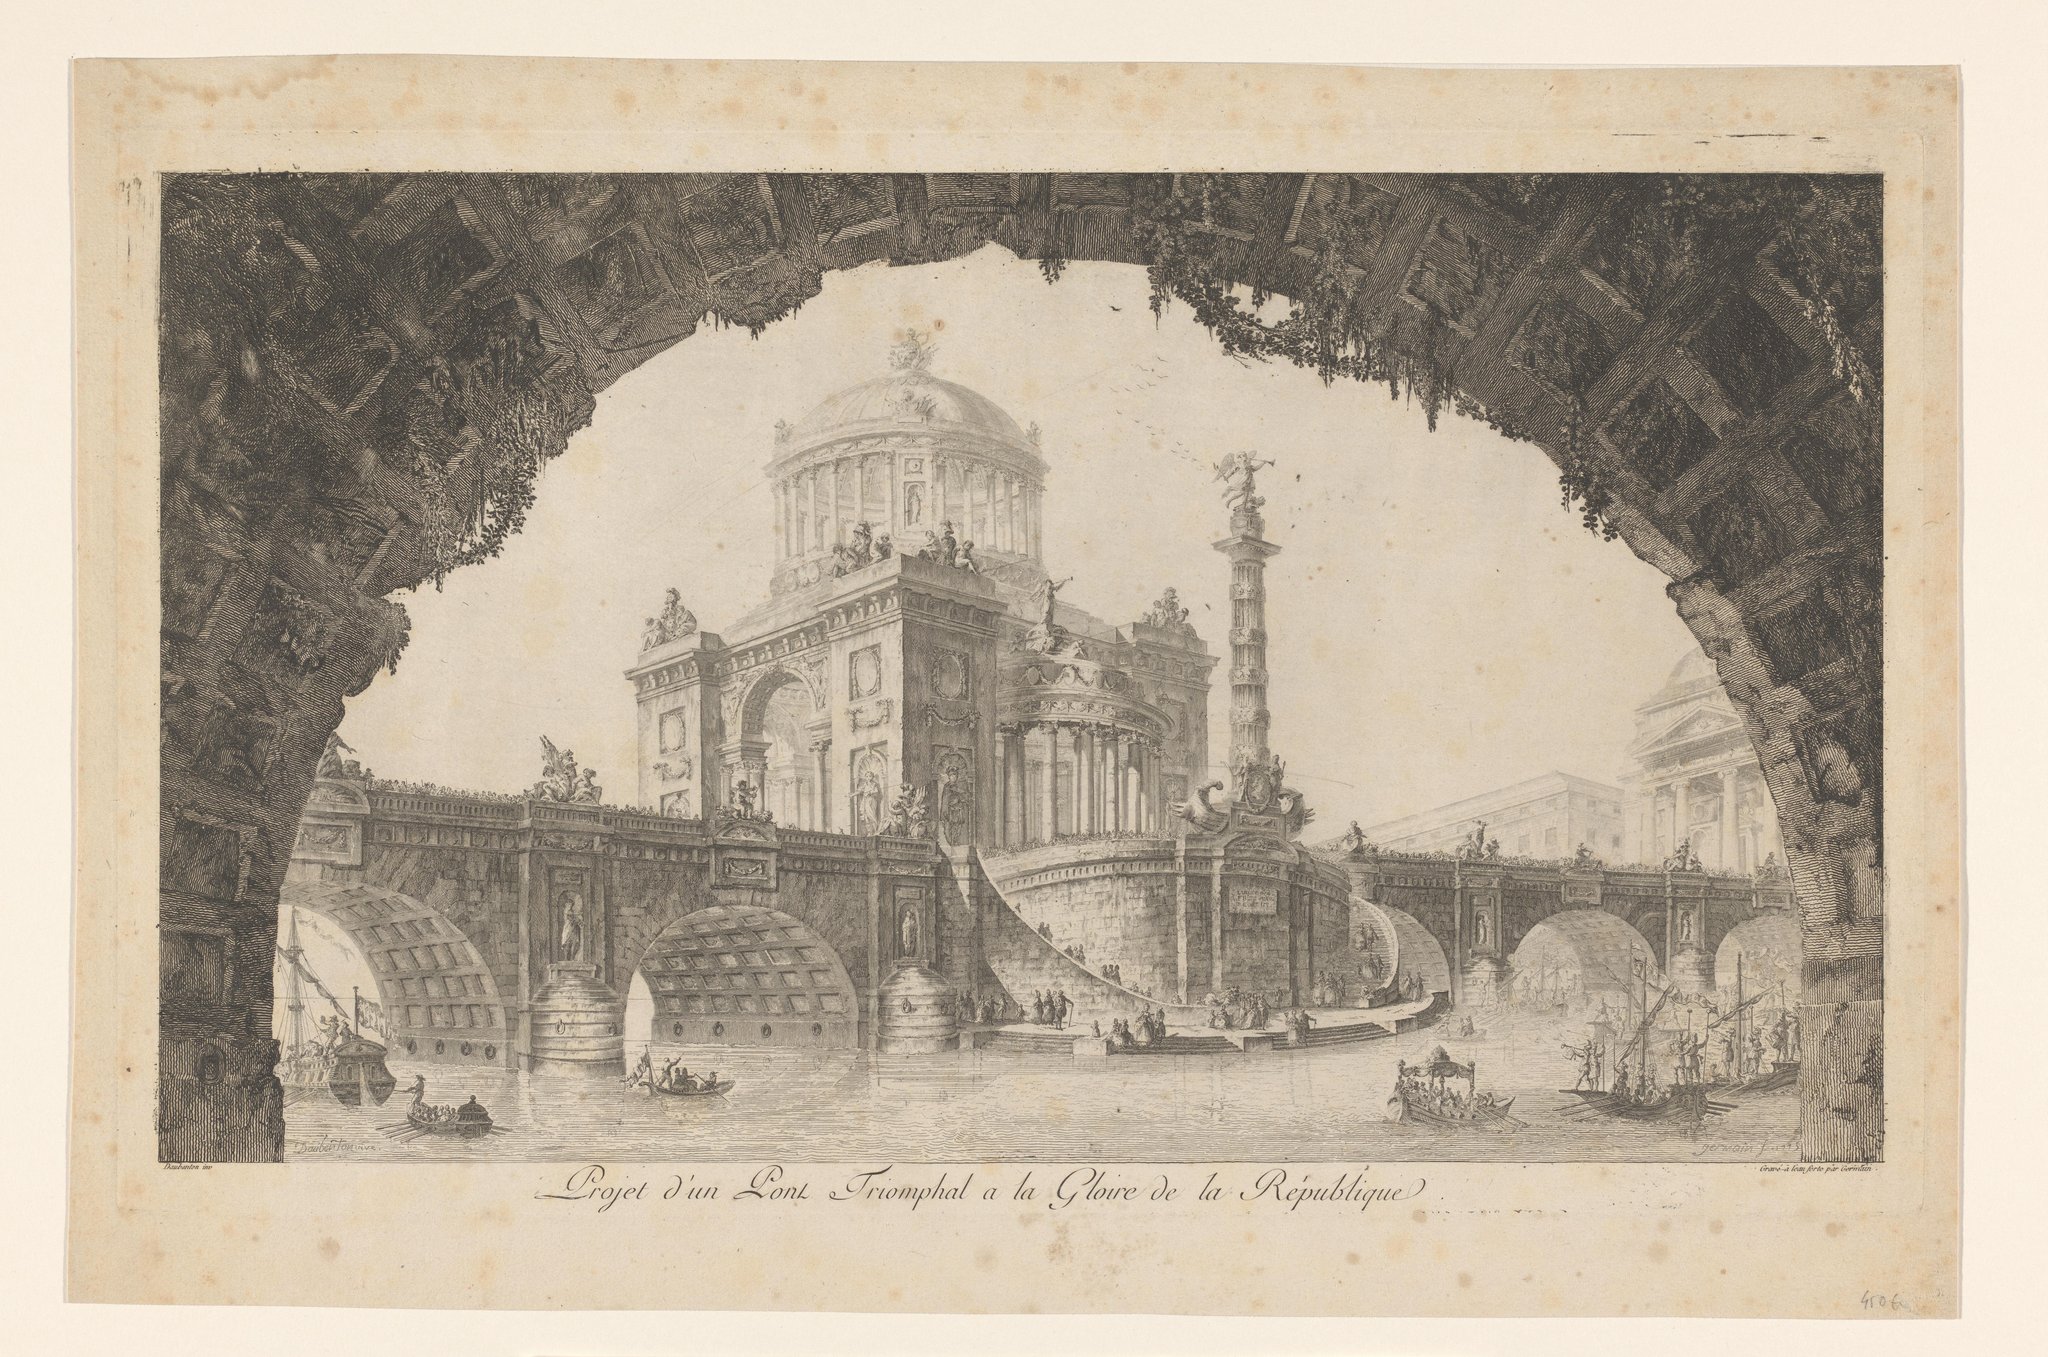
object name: print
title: Ontwerp voor een triomfbrug ter meerdere glorie van de (Franse) Republiek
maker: louis germain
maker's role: print maker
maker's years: 1733-1791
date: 1789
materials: ink, paper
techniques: etching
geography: paris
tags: bridge in city across river, canal, etc.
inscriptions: collector's mark: Lugt 2760, collector's mark: Lugt 2228